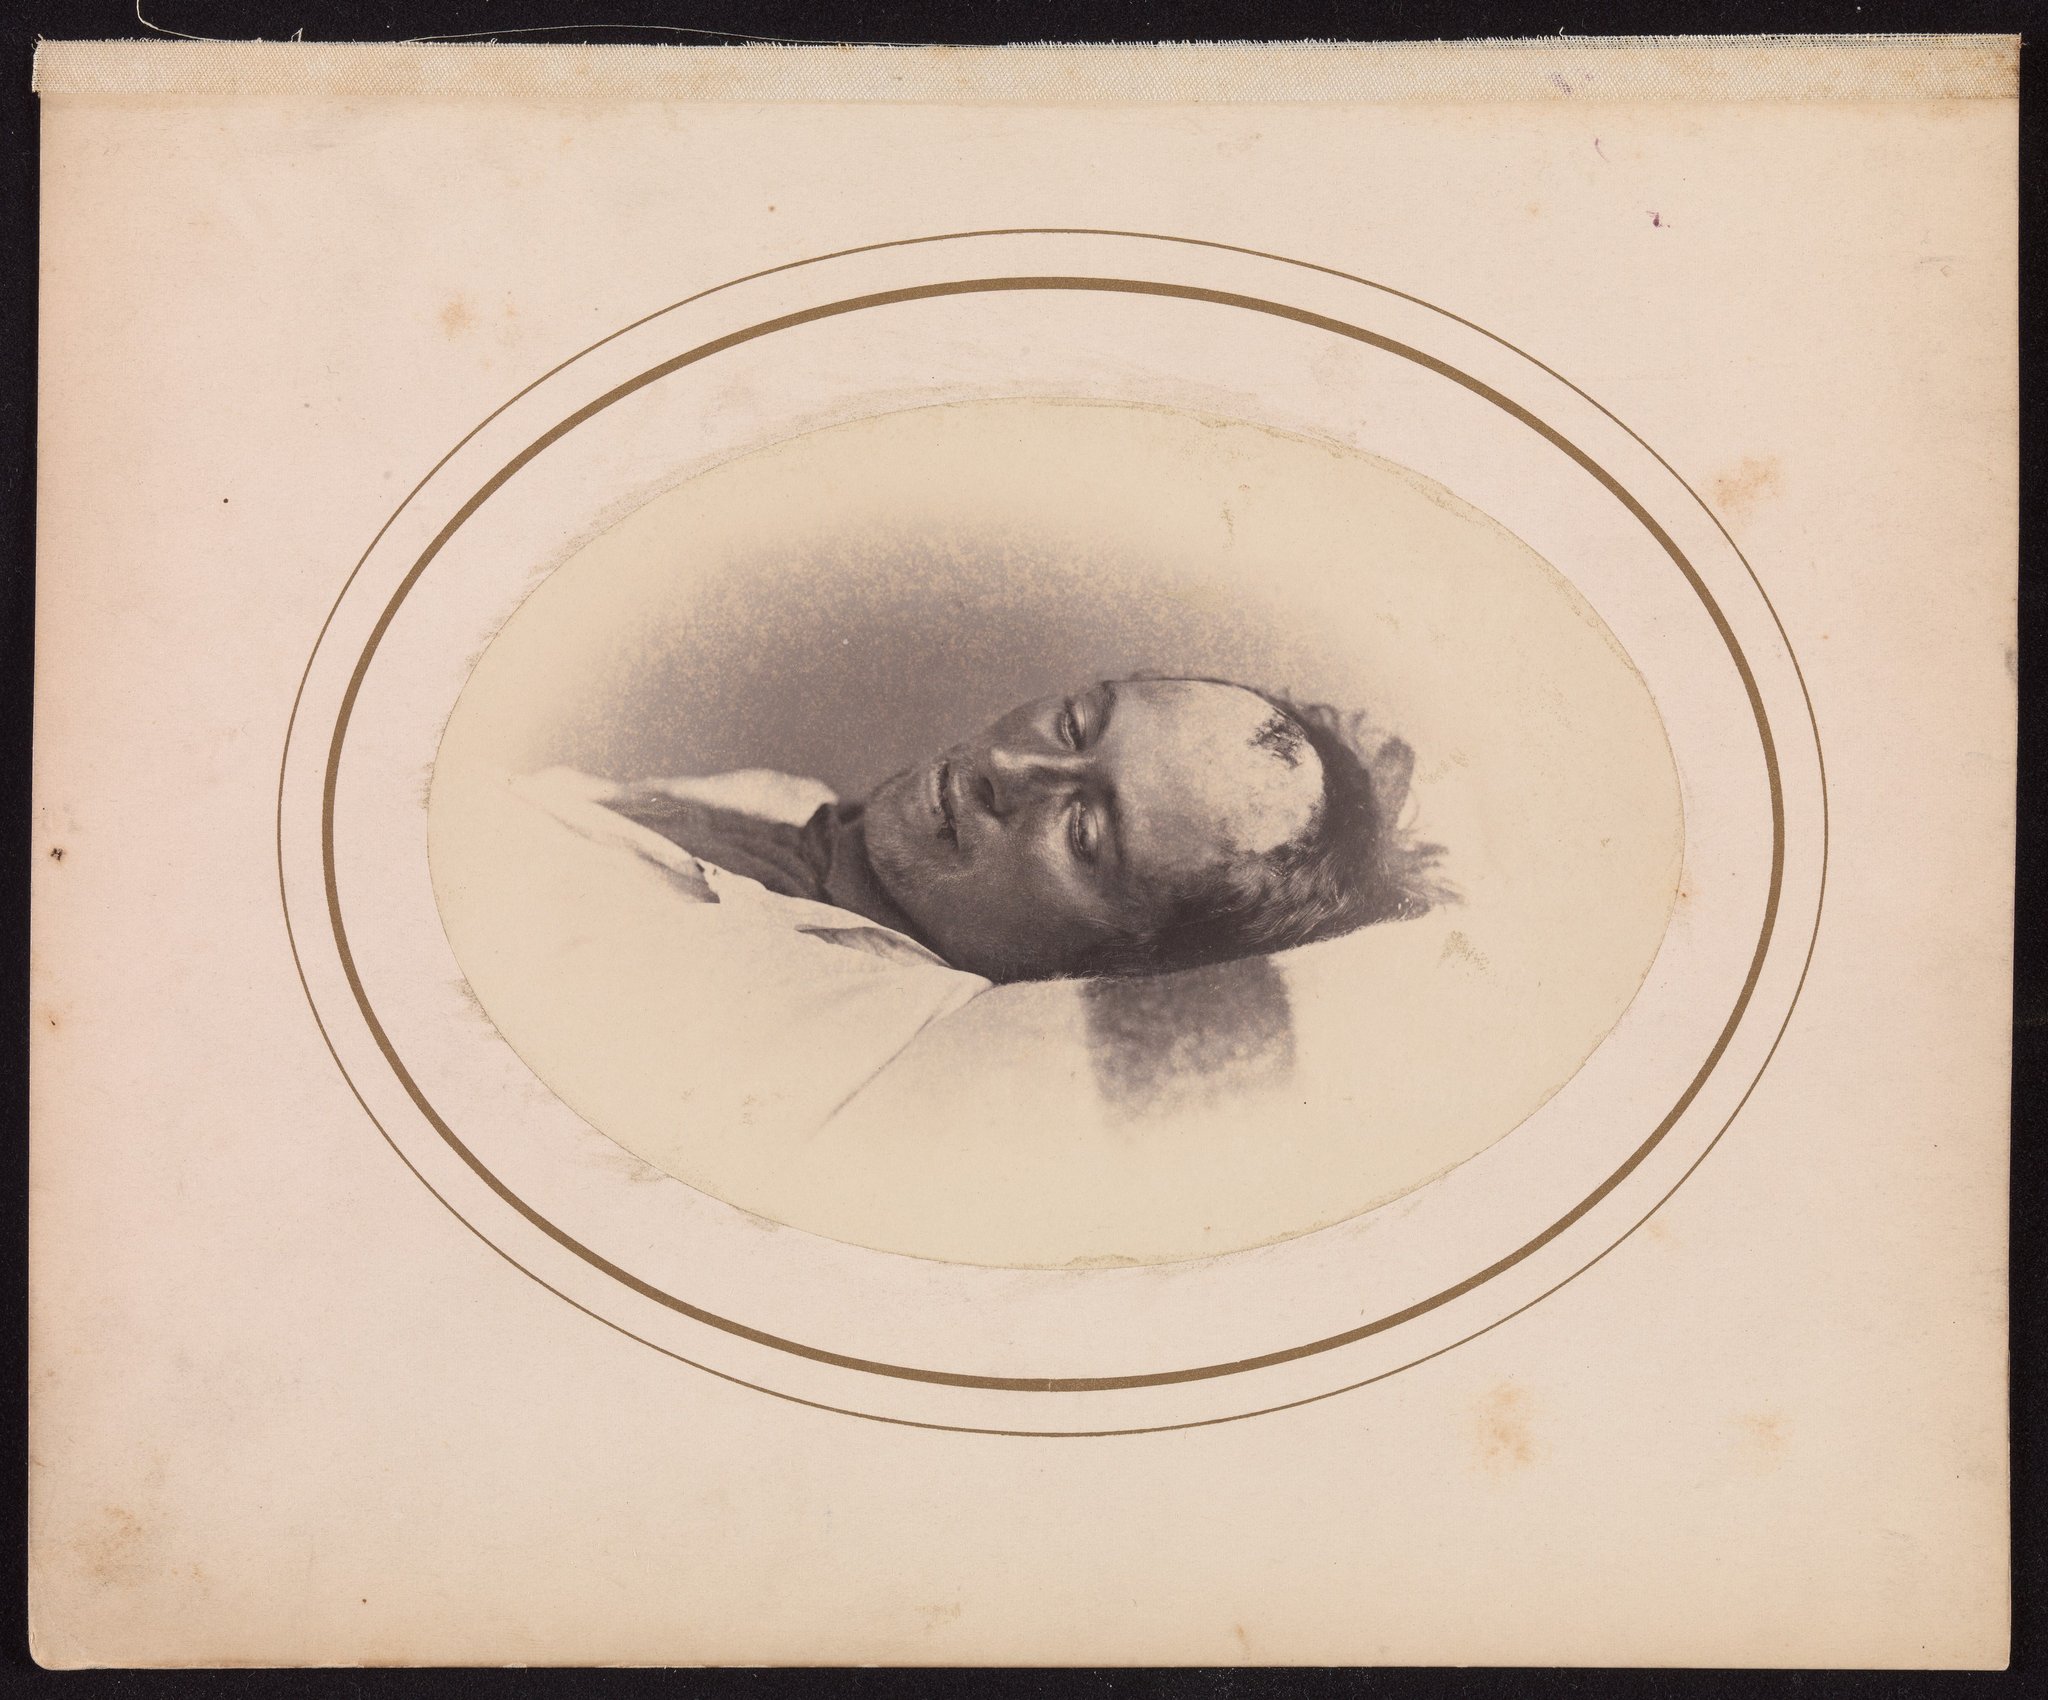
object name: photograph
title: Private Dennis Sullivan, Company E, Second Virginia Cavalry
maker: reed brockway bontecou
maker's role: artist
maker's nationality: american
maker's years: 1824-1907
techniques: albumen silver print, glass negative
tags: soldiers,american civil war,men,portraits